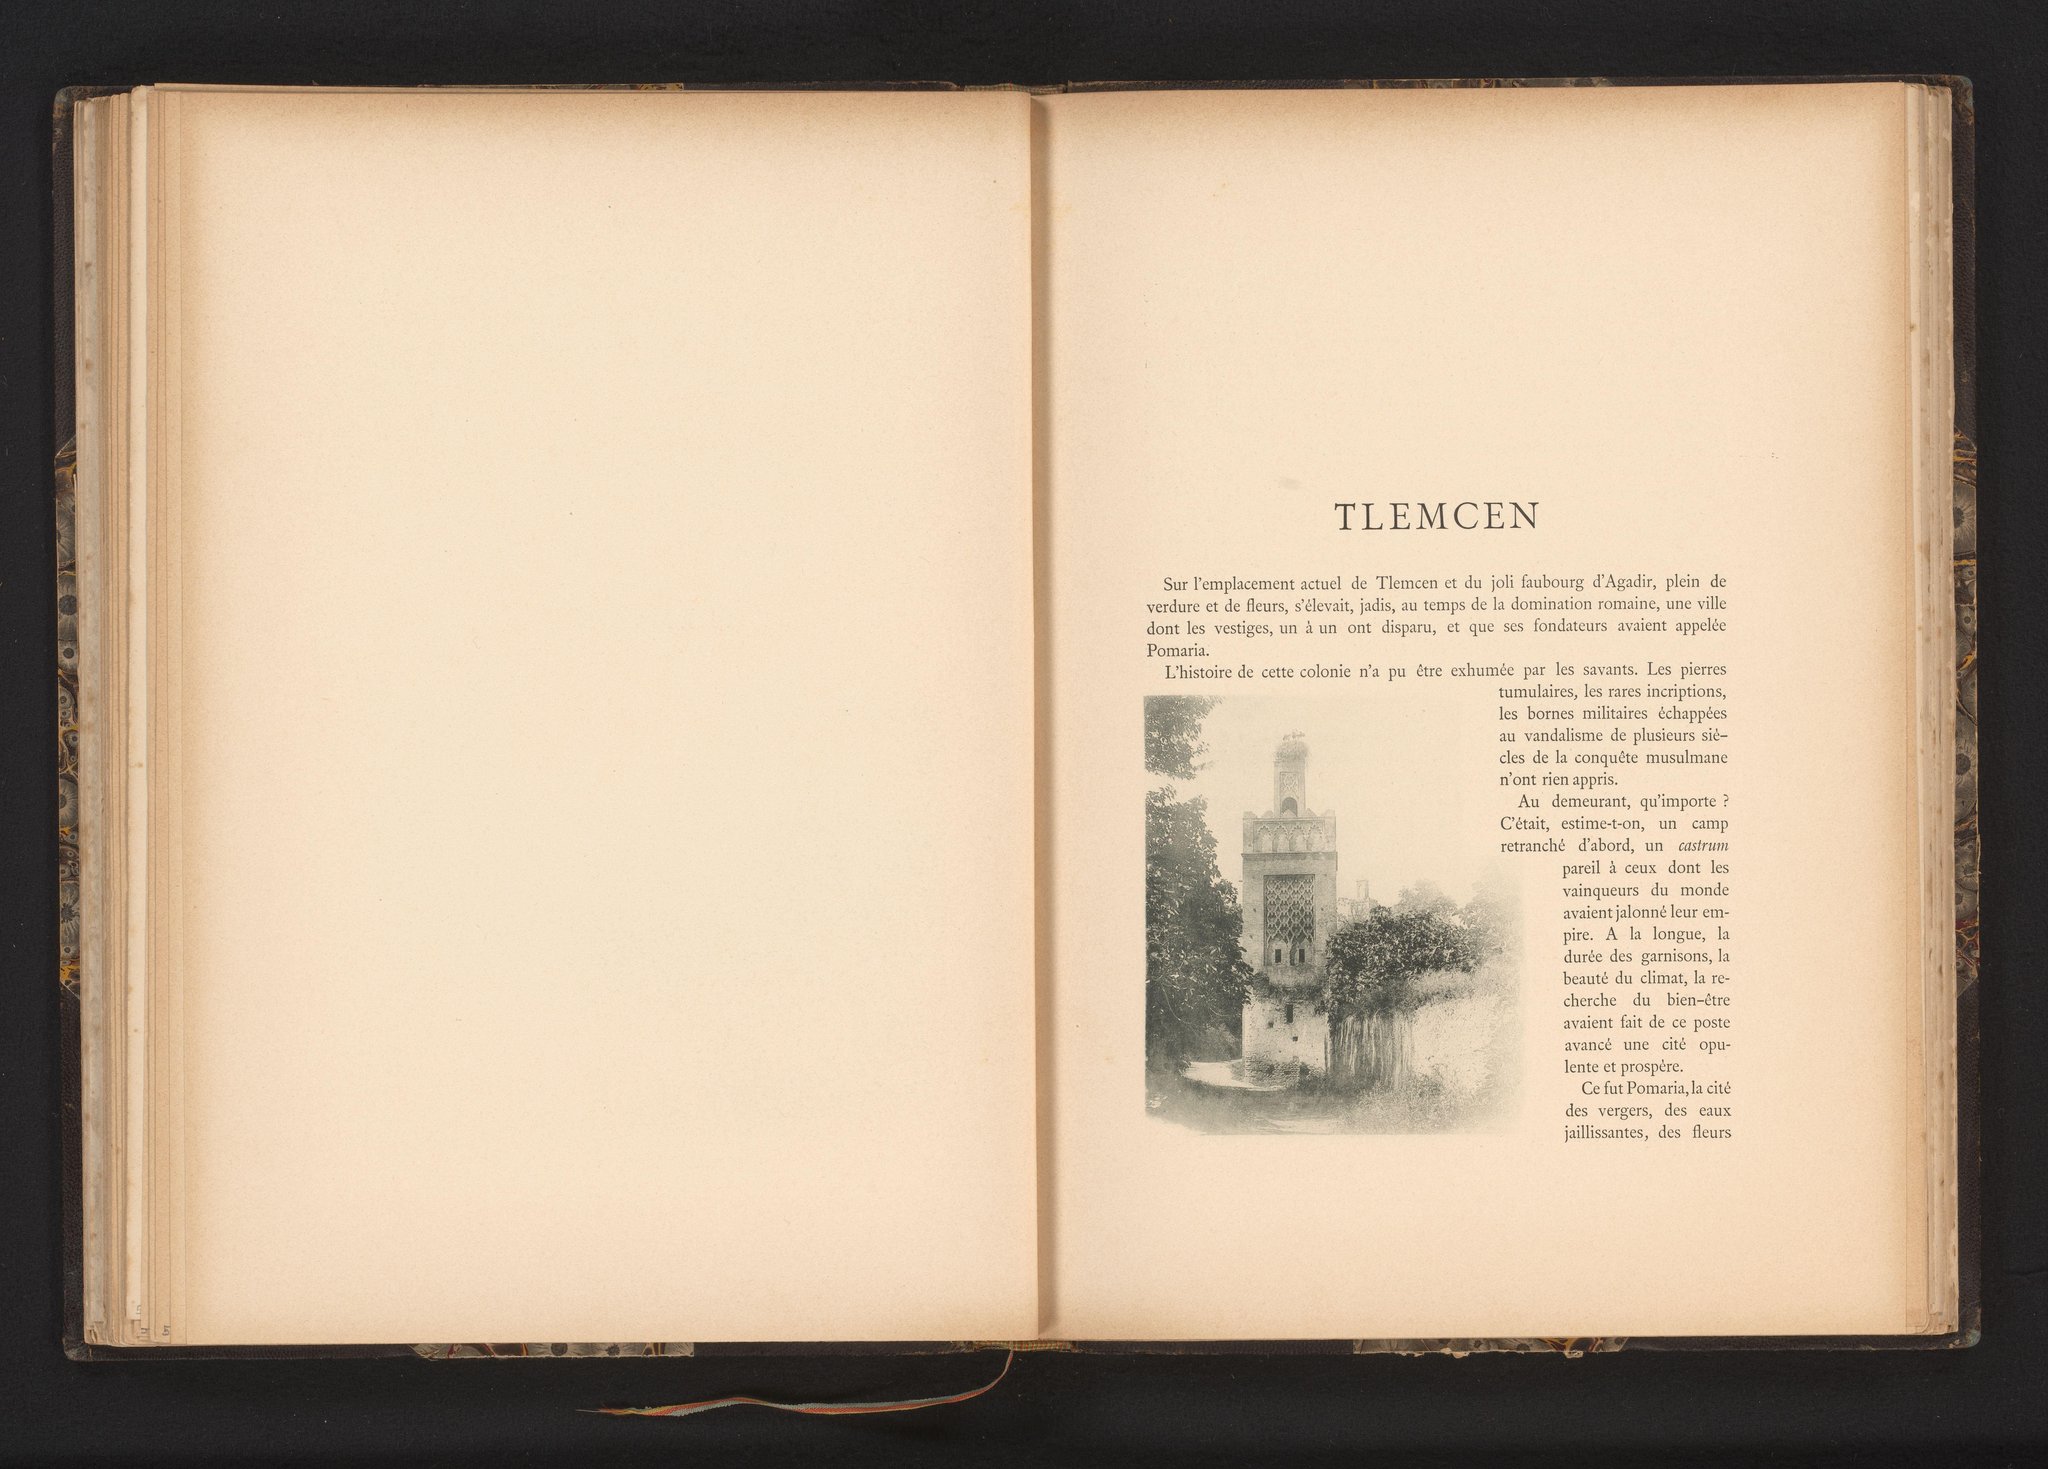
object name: photomechanical print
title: Gezicht op de toren van de grote moskee van Tlemcen, Algerije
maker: jules gervais-courtellemont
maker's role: fotograaf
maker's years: 1863-1931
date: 1888-1893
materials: paper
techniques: photograph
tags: temple, shrine ~ islam, mohammedanism